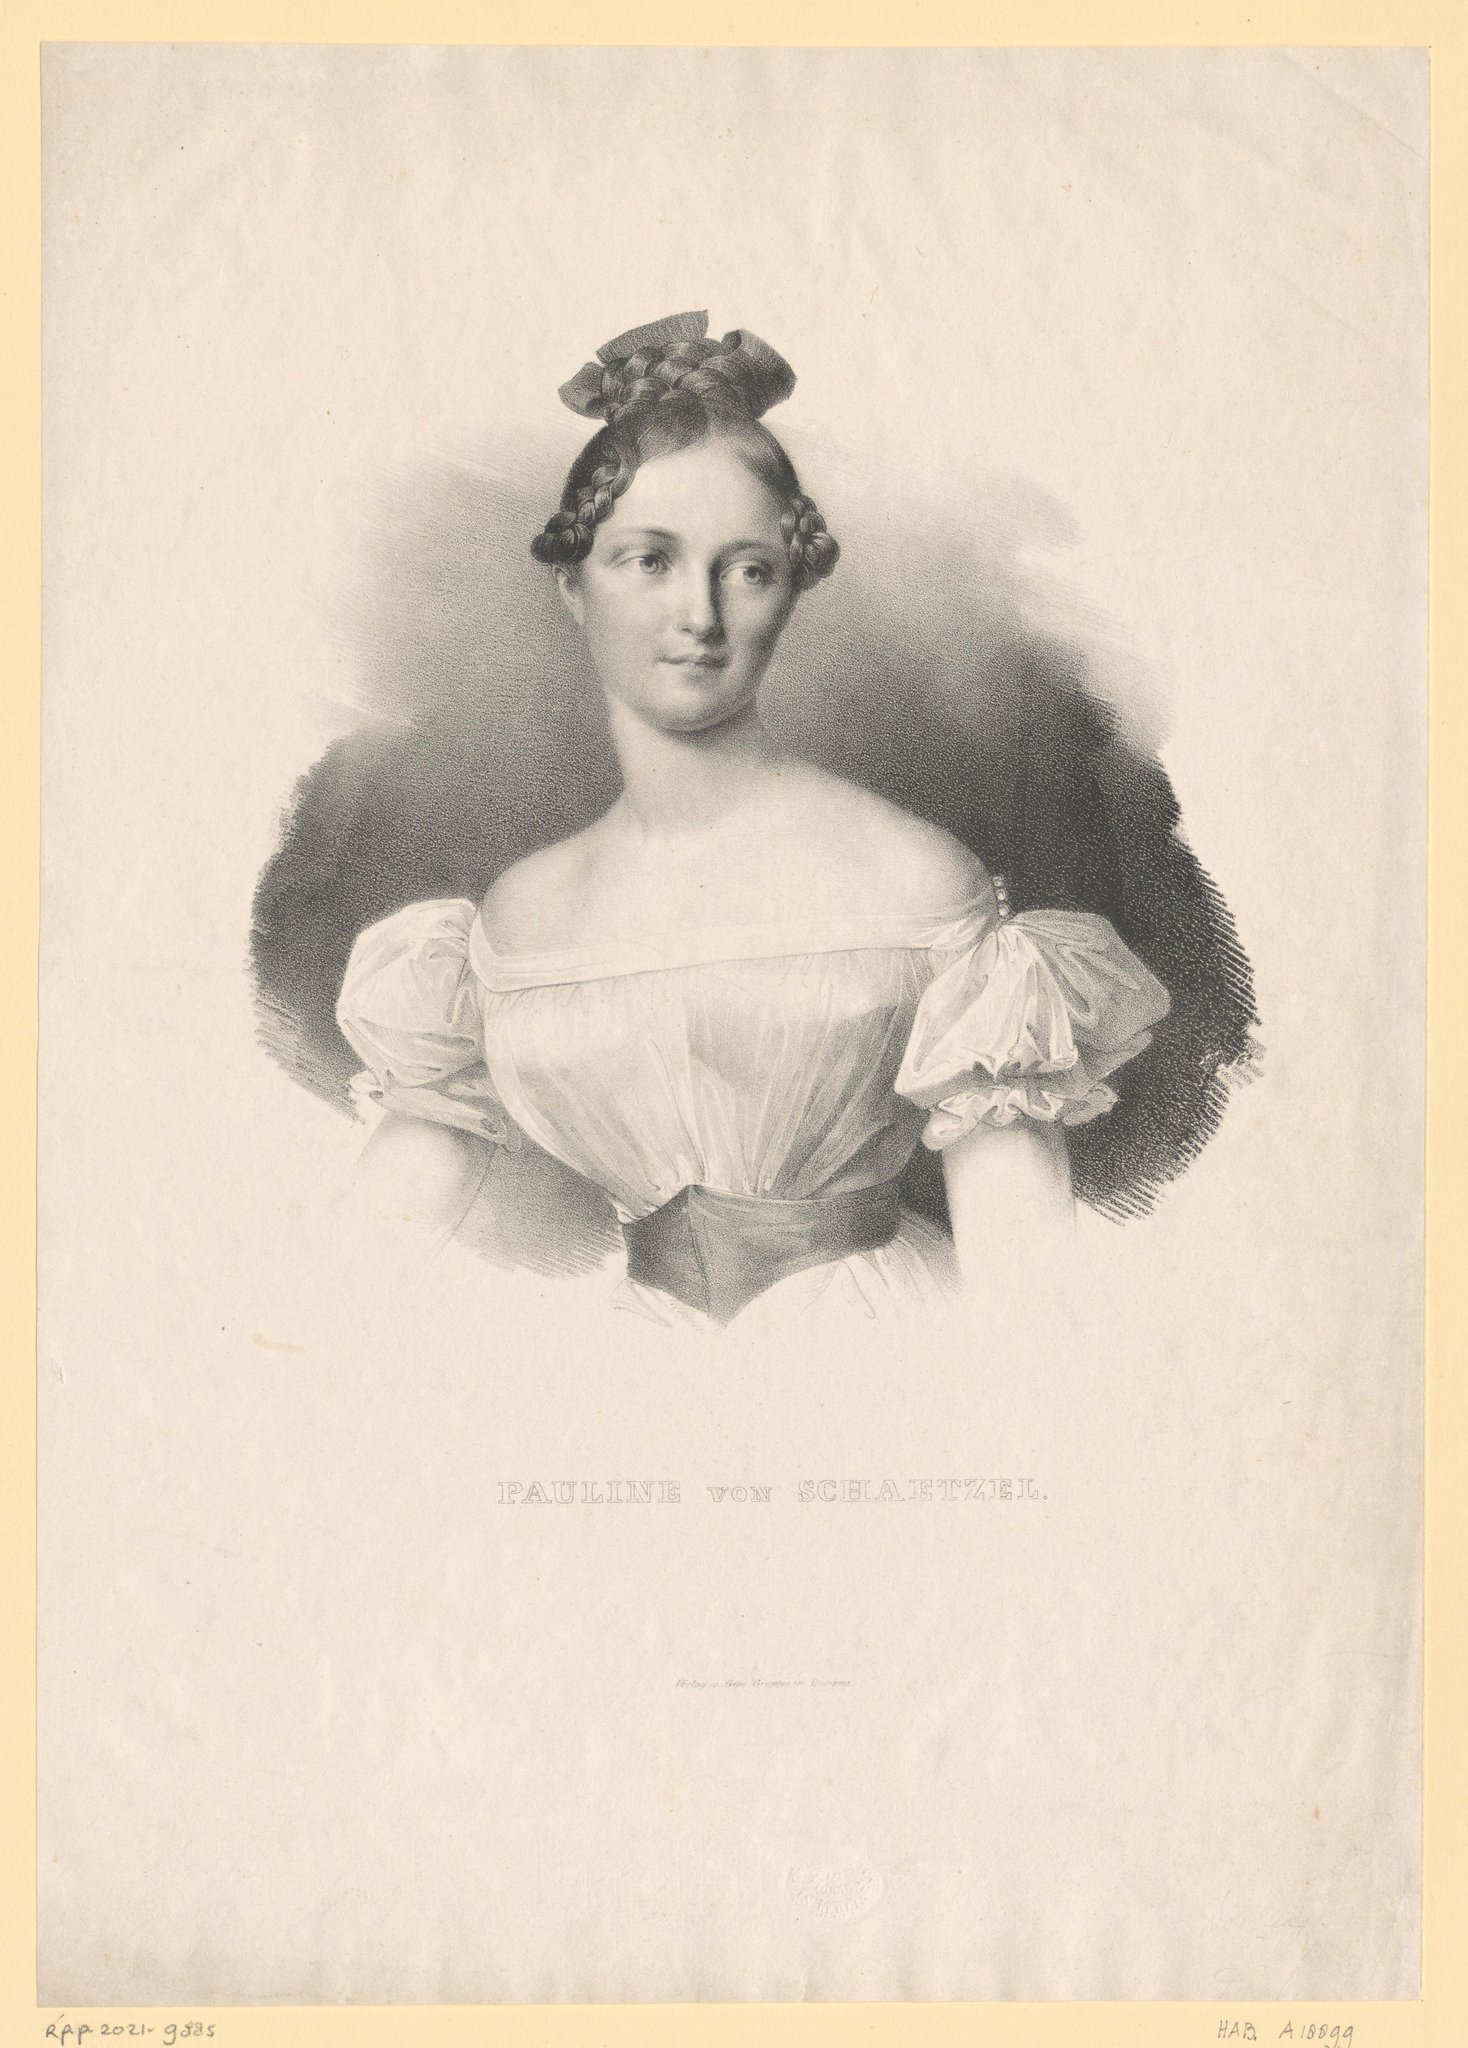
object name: print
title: Portret van Pauline von Schätzel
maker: Anonymous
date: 1827-1899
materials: paper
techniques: lithograph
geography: berlin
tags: adult woman, historical persons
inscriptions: check stamp: Lugt 5415